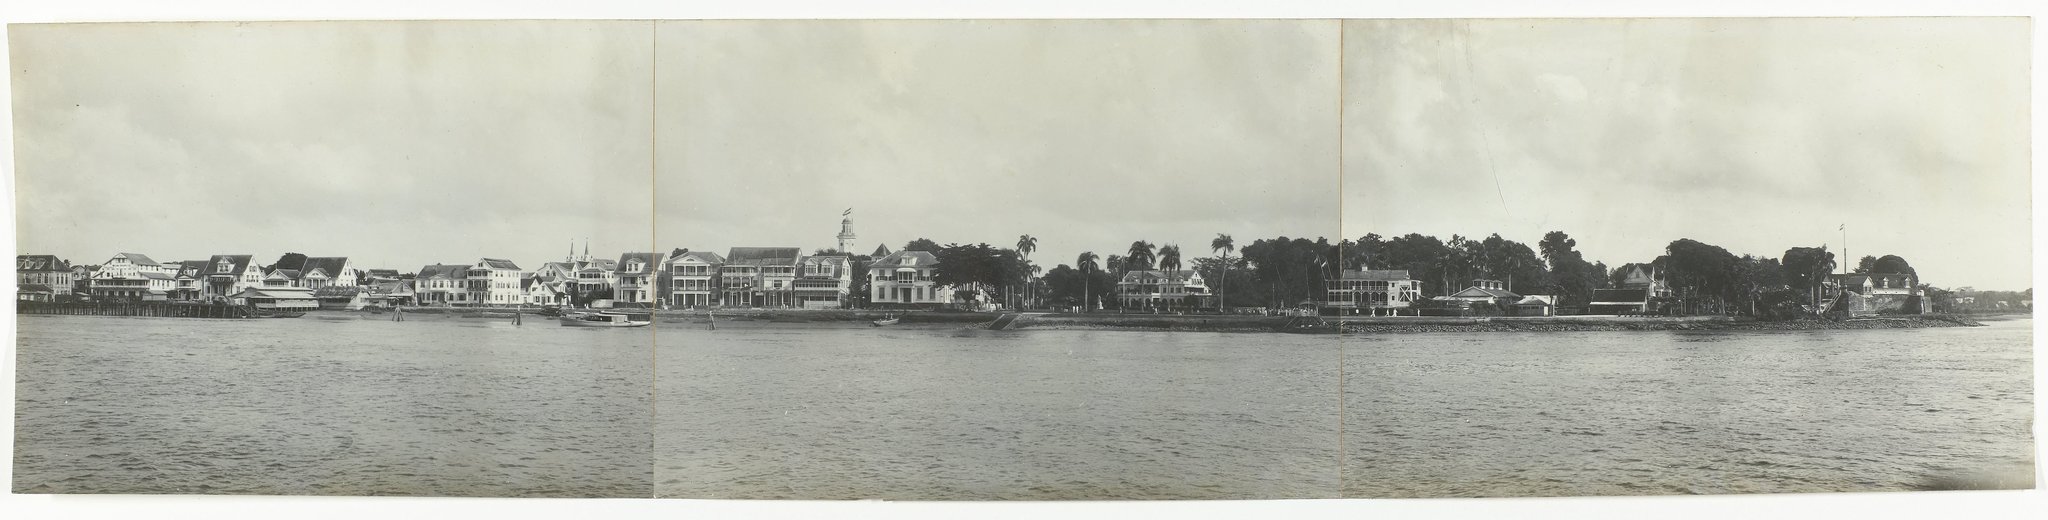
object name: panoramic photograph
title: Panorama van de Waterkant van Paramaribo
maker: augusta curiel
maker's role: fotograaf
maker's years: 1873-1937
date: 1925-1937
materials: photographic support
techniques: gelatin silver print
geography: suriname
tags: waterkant, paramaribo (stad)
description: Panoramafoto van Paramaribo in 3 aaneengesloten delen. Er staan enkele belangrijke gebouwen op de foto, zoals Fort Zeelandia, het Gouvernementshuis, de sociëteit, de kathedraal en het stadhuis met de Nederlandse driekleur.